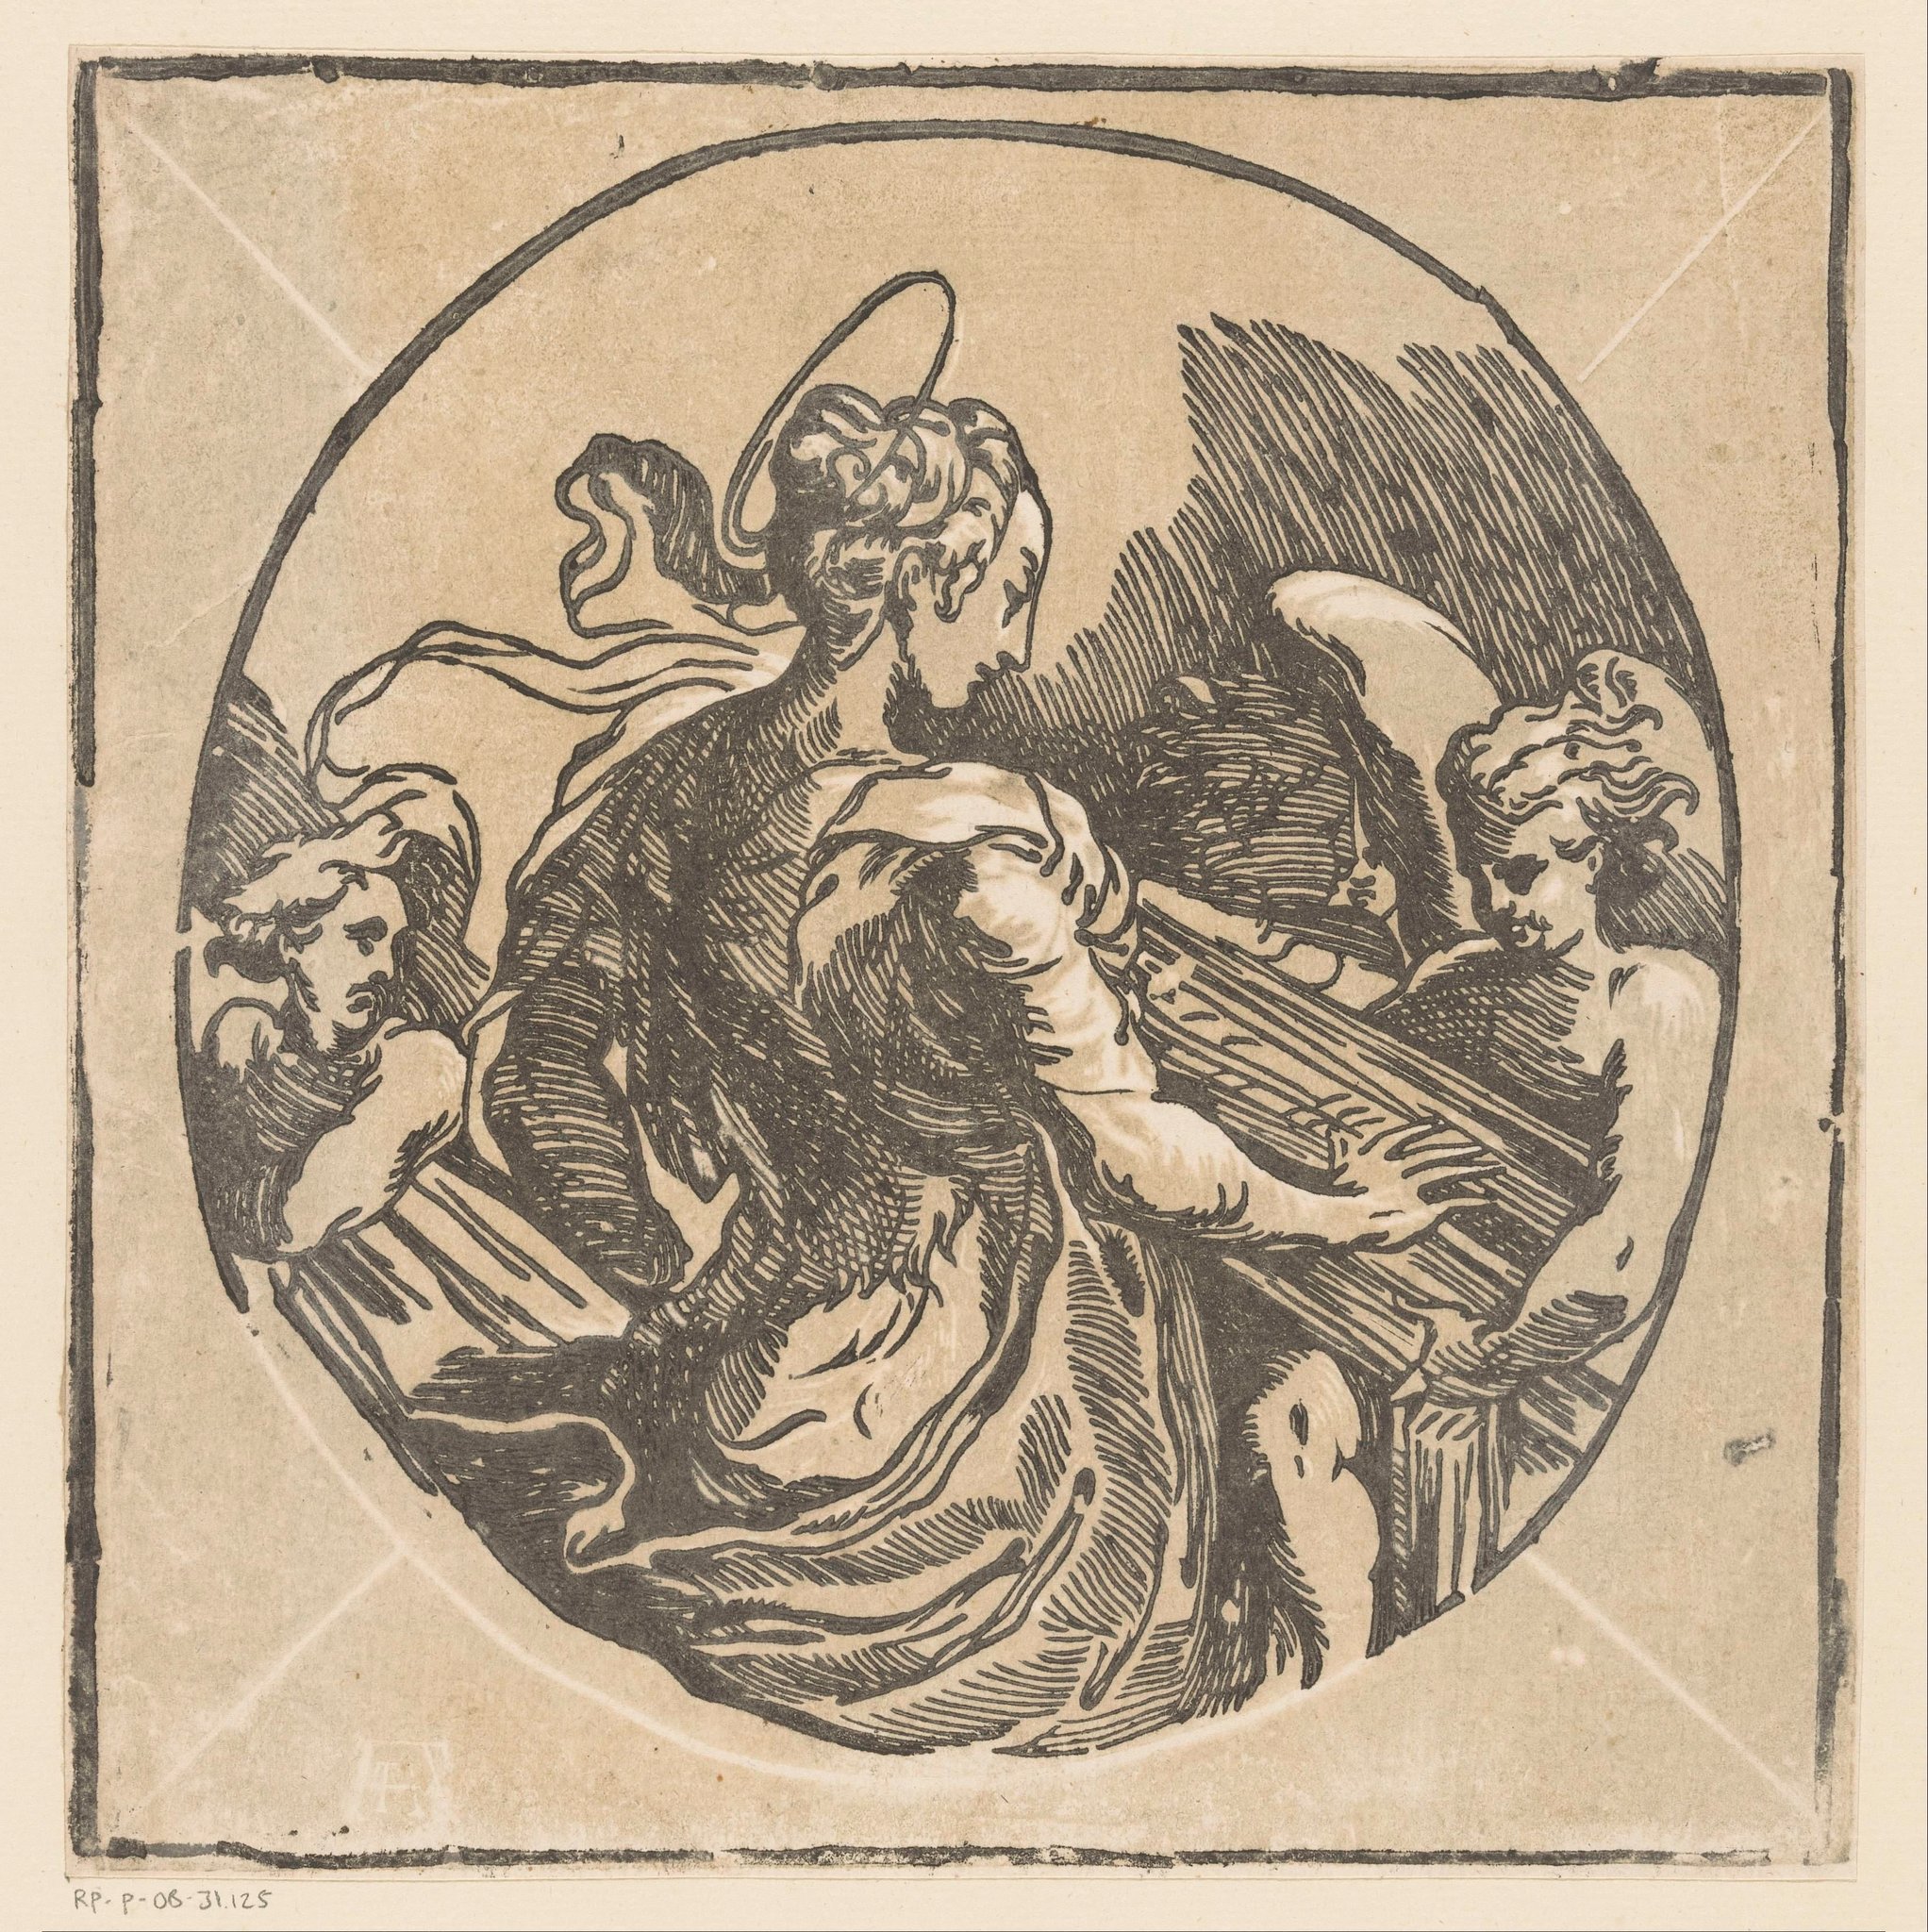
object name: print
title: Heilige Cecilia musicerend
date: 1568-1629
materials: paper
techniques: woodcut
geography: italy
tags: angels, st. cecilia as patroness of music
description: De heilige Cecilia, spelend op een toetsinstrument en omringd door engelen.